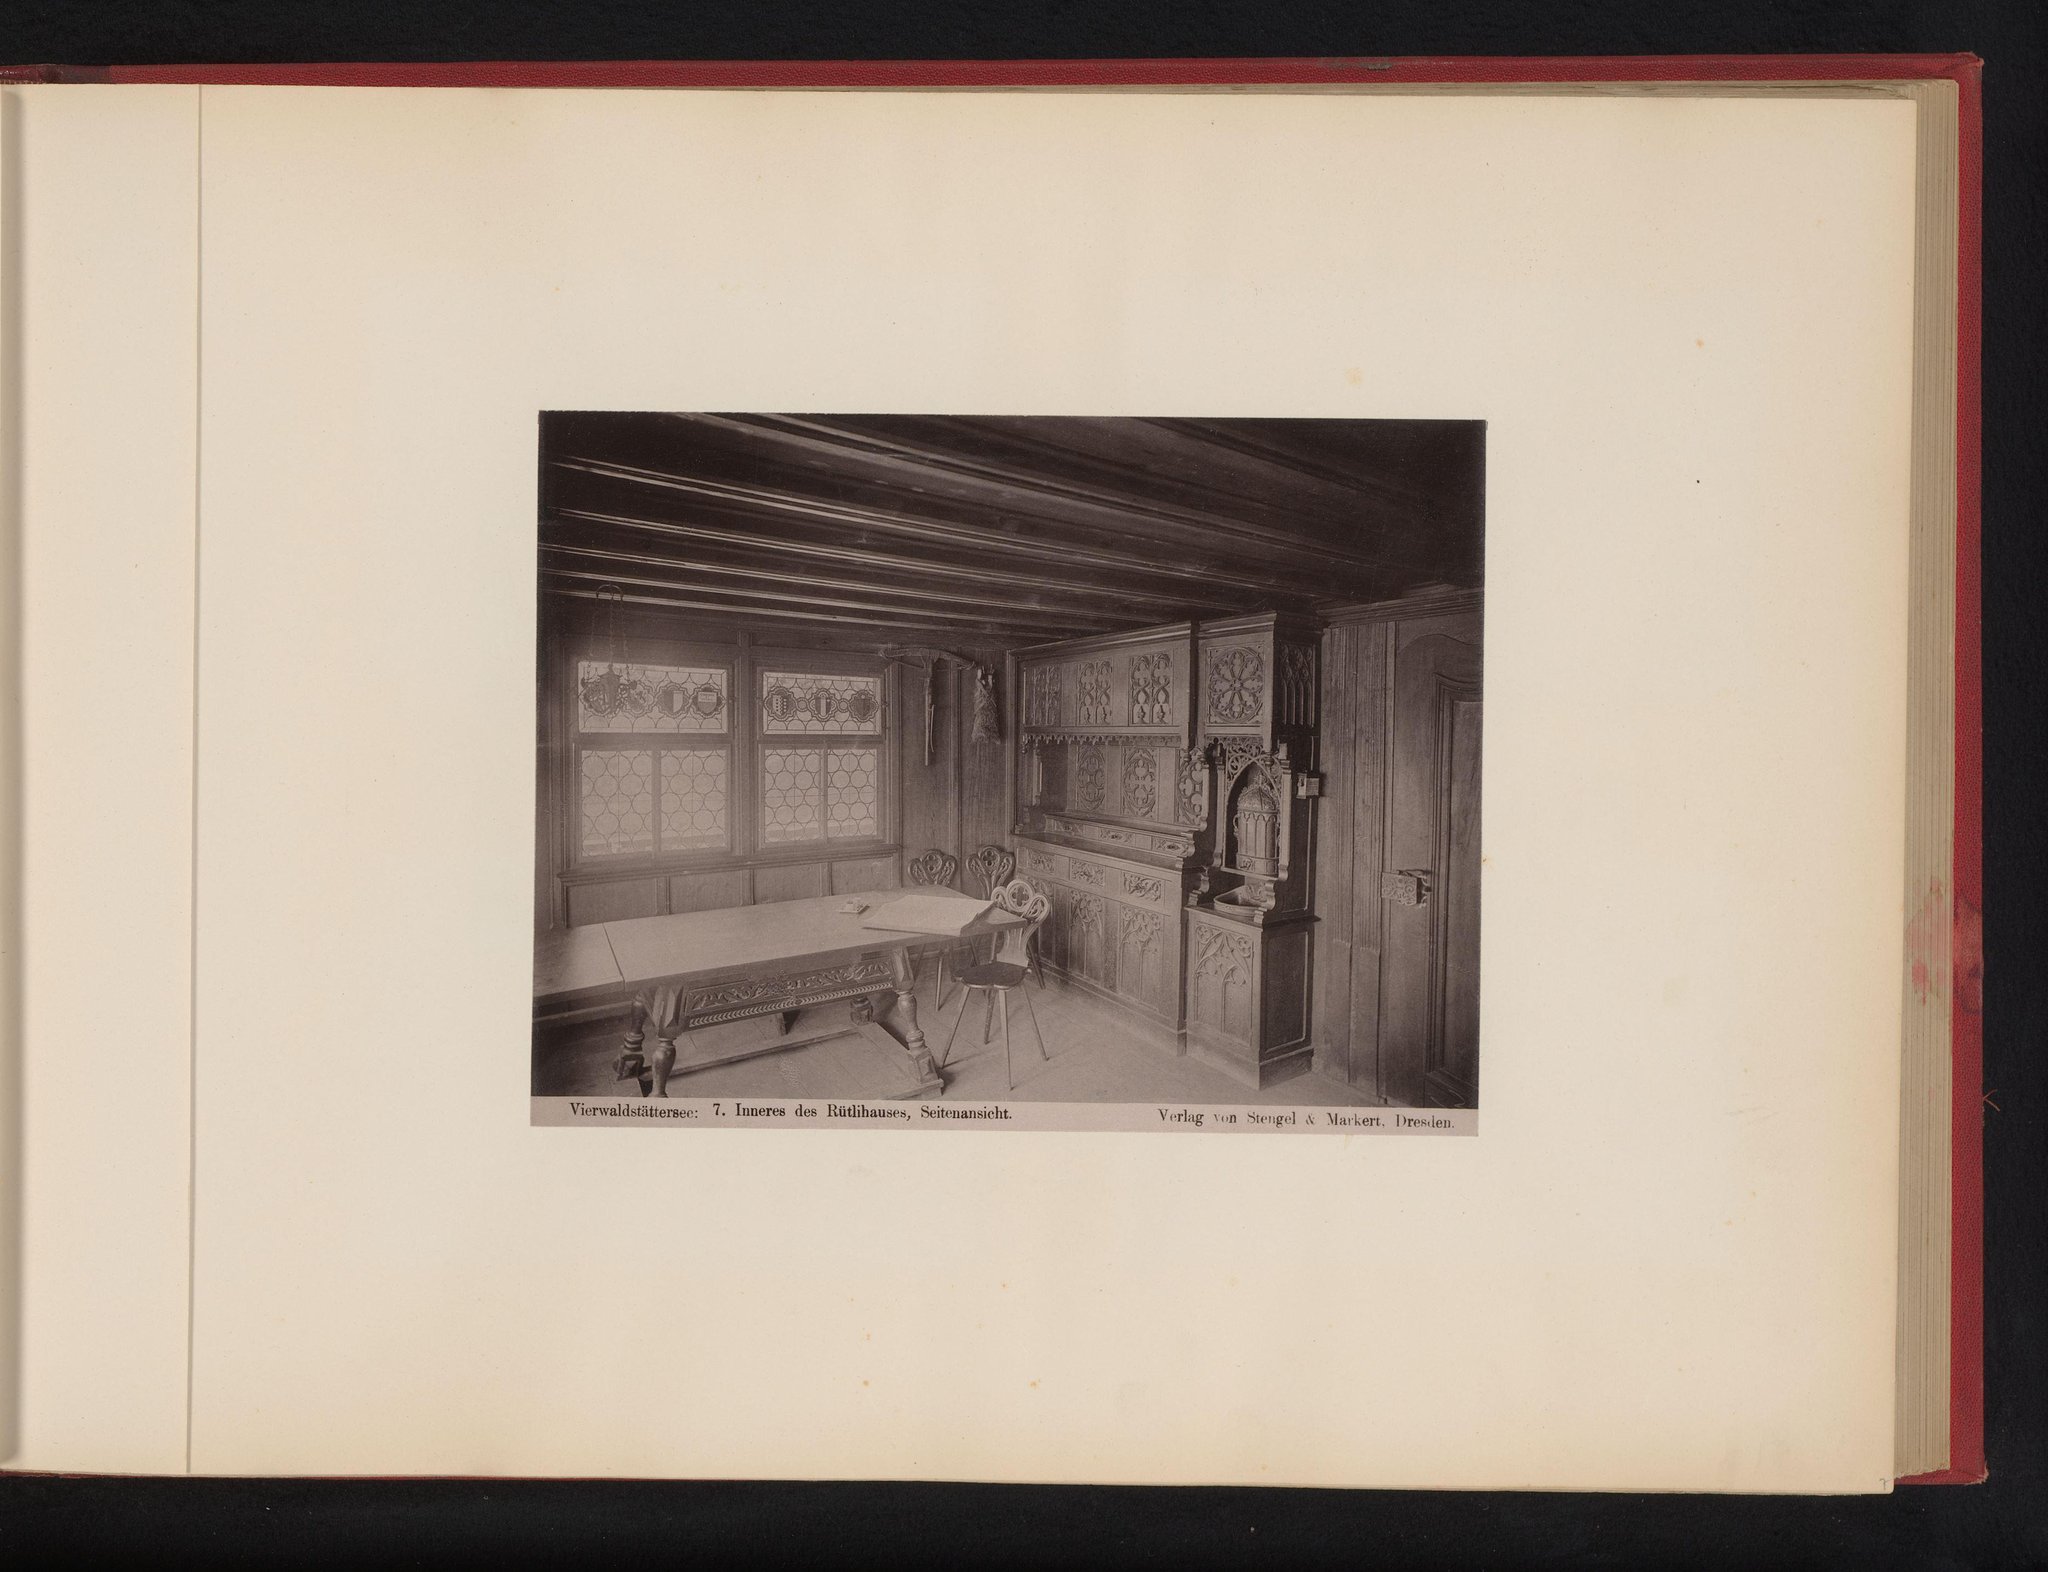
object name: photomechanical print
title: Interieur van een woning in de alpenweide Rütli te Seelisberg, Zwitserland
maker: Anonymous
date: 1860-1900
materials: paper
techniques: photograph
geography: dresden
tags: interior of the house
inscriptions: inscription: ‘Vierwaldstättersee: 7. Inneres des Rütlihauses, Seitansicht/ Verlag von Stengel & Markert, Dresden’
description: Deze prent maakt deel uit van een album.